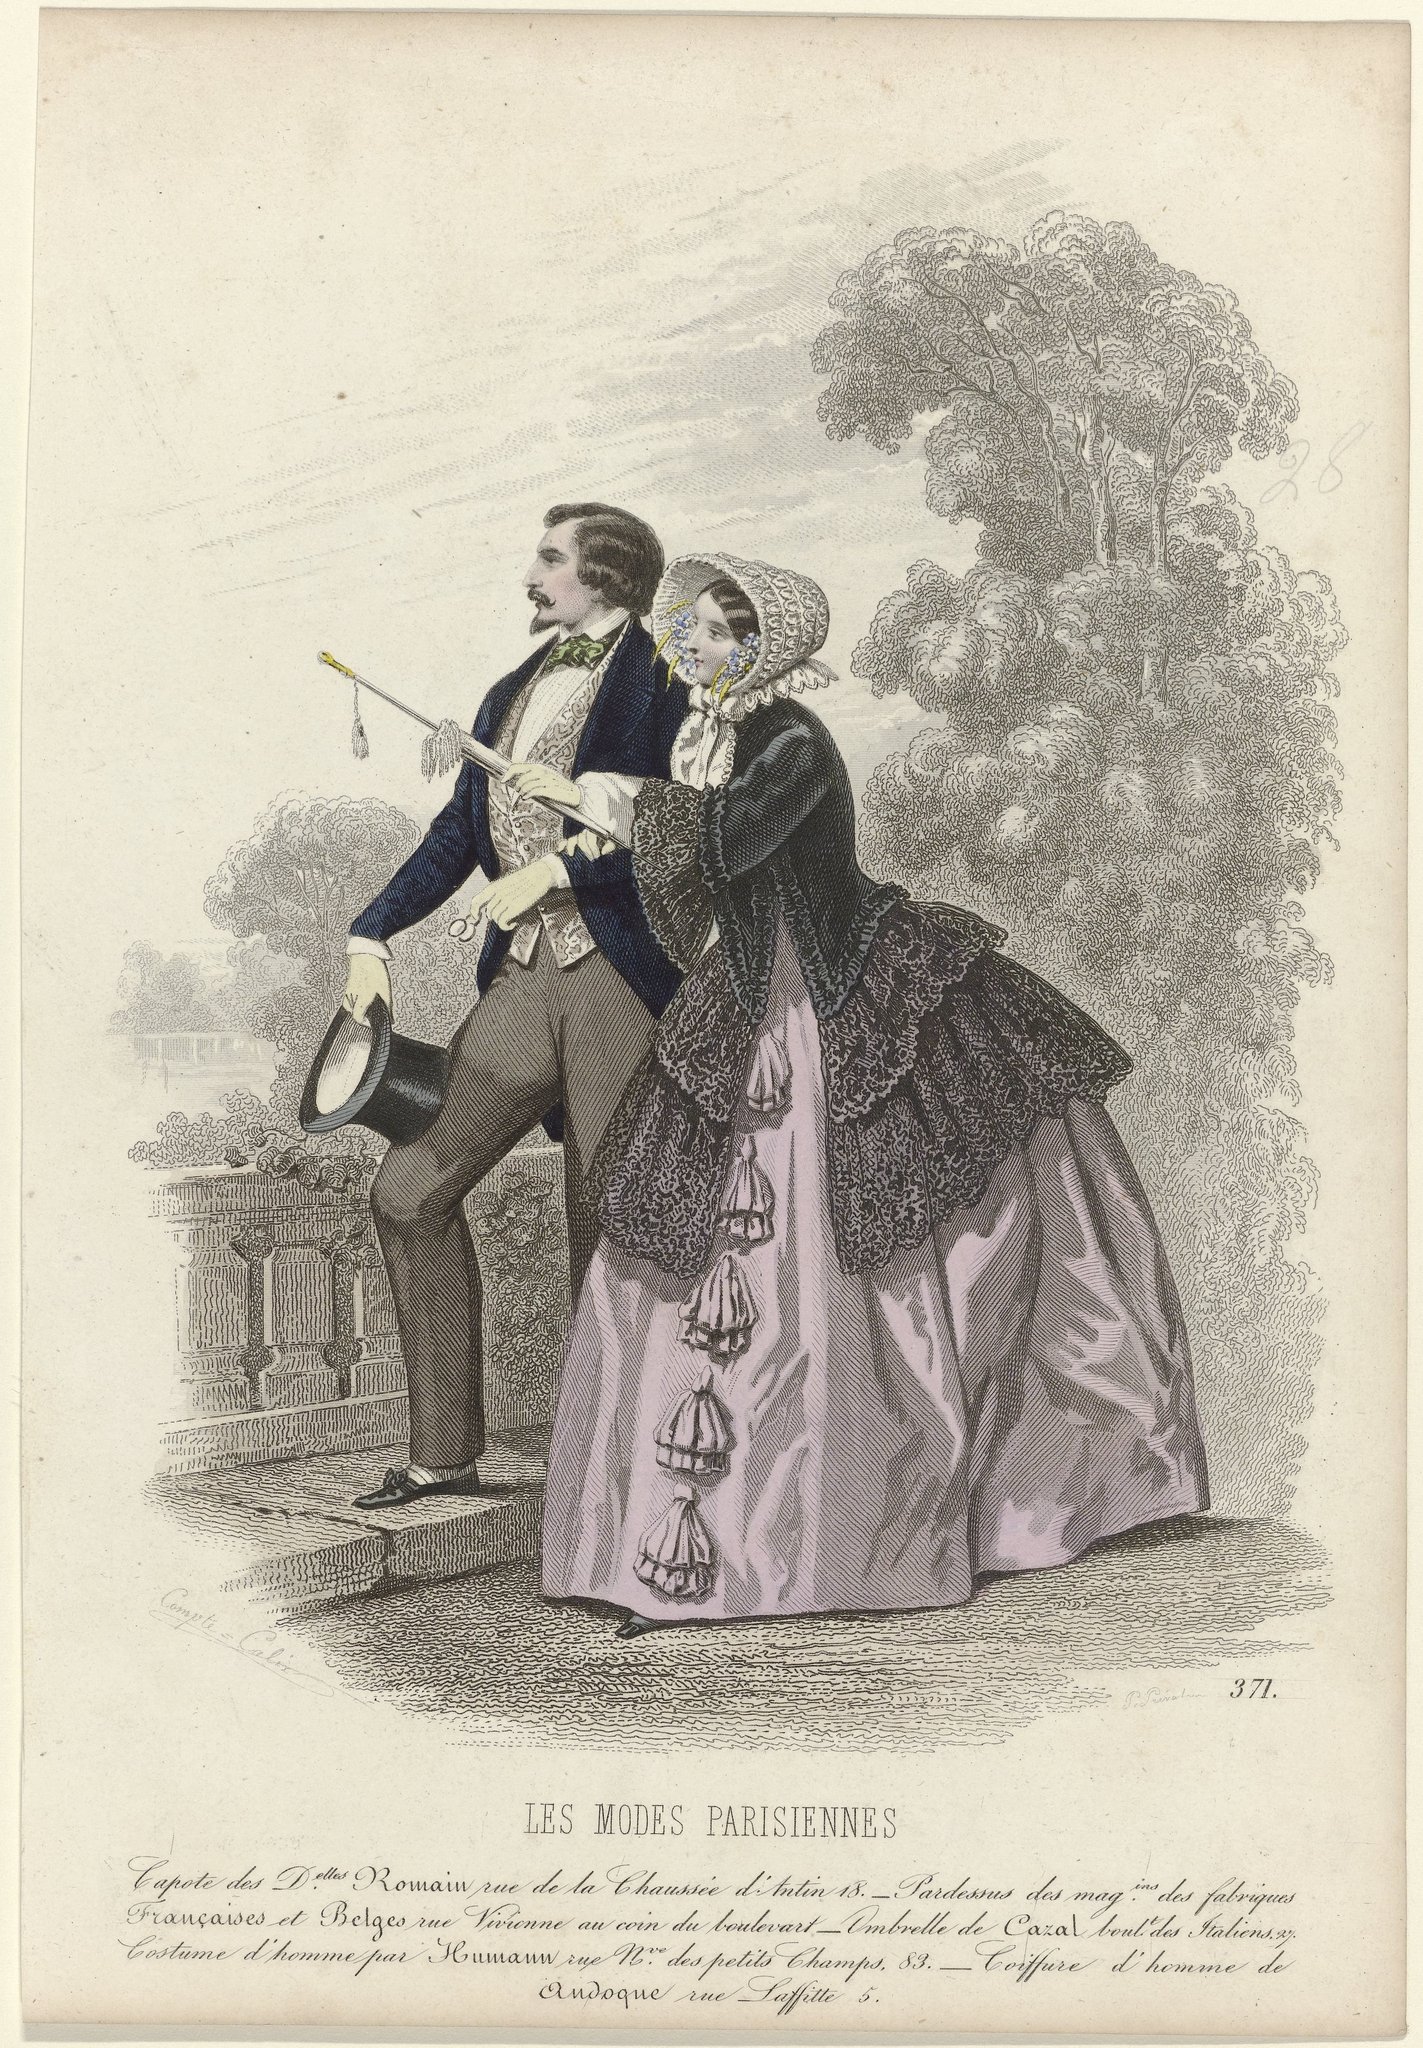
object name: fashion print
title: Les Modes Parisiennes, 1851, No. 371 : Capote des D.elles Romain (...)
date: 1851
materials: paper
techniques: engraving, hand coloring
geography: paris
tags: clothing for the upper part of the body (vest) (+ men's clothes), head-gear (capote) (+ women's clothes), trousers, breeches, etc. (pantalon) (+ men's clothes), coat (+ women's clothes), coat (+ men's clothes), dress, gown (pardessus) (+ women's clothes), styles of hairdress, fashion plates, skirt (+ women's clothes), gloves, mittens, etc. (+ women's clothes), gloves, mittens, etc. (+ men's clothes), parasol, sunshade (+ women's clothes)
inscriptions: caption: ‘Capote des D.elles Romain rue de la Chaussée d'Antin 18. _ Pardessus des mag.ins des fabriques Françaises et Belges rue Vivienne au coin du boulevart _ Ombrelle de Cazal boul.t des Italiens. 27. Costume d'homme par Humann rue N.ve des petits Champs, 83. _ Coiffure d'homme de Andoque rue Laffitte 5.’, title: ‘Les Modes Parisiennes.’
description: Een gearmd paar, staande bij een balustrade. De vrouw wijst met haar parasol. Zij draagt een 'Pardessus' over de paarse japon, een 'capote' op het hoofd. Mannenkostuum van Humann. Prent uit het modetijdschrift Les Modes Parisiennes (1843-1885).